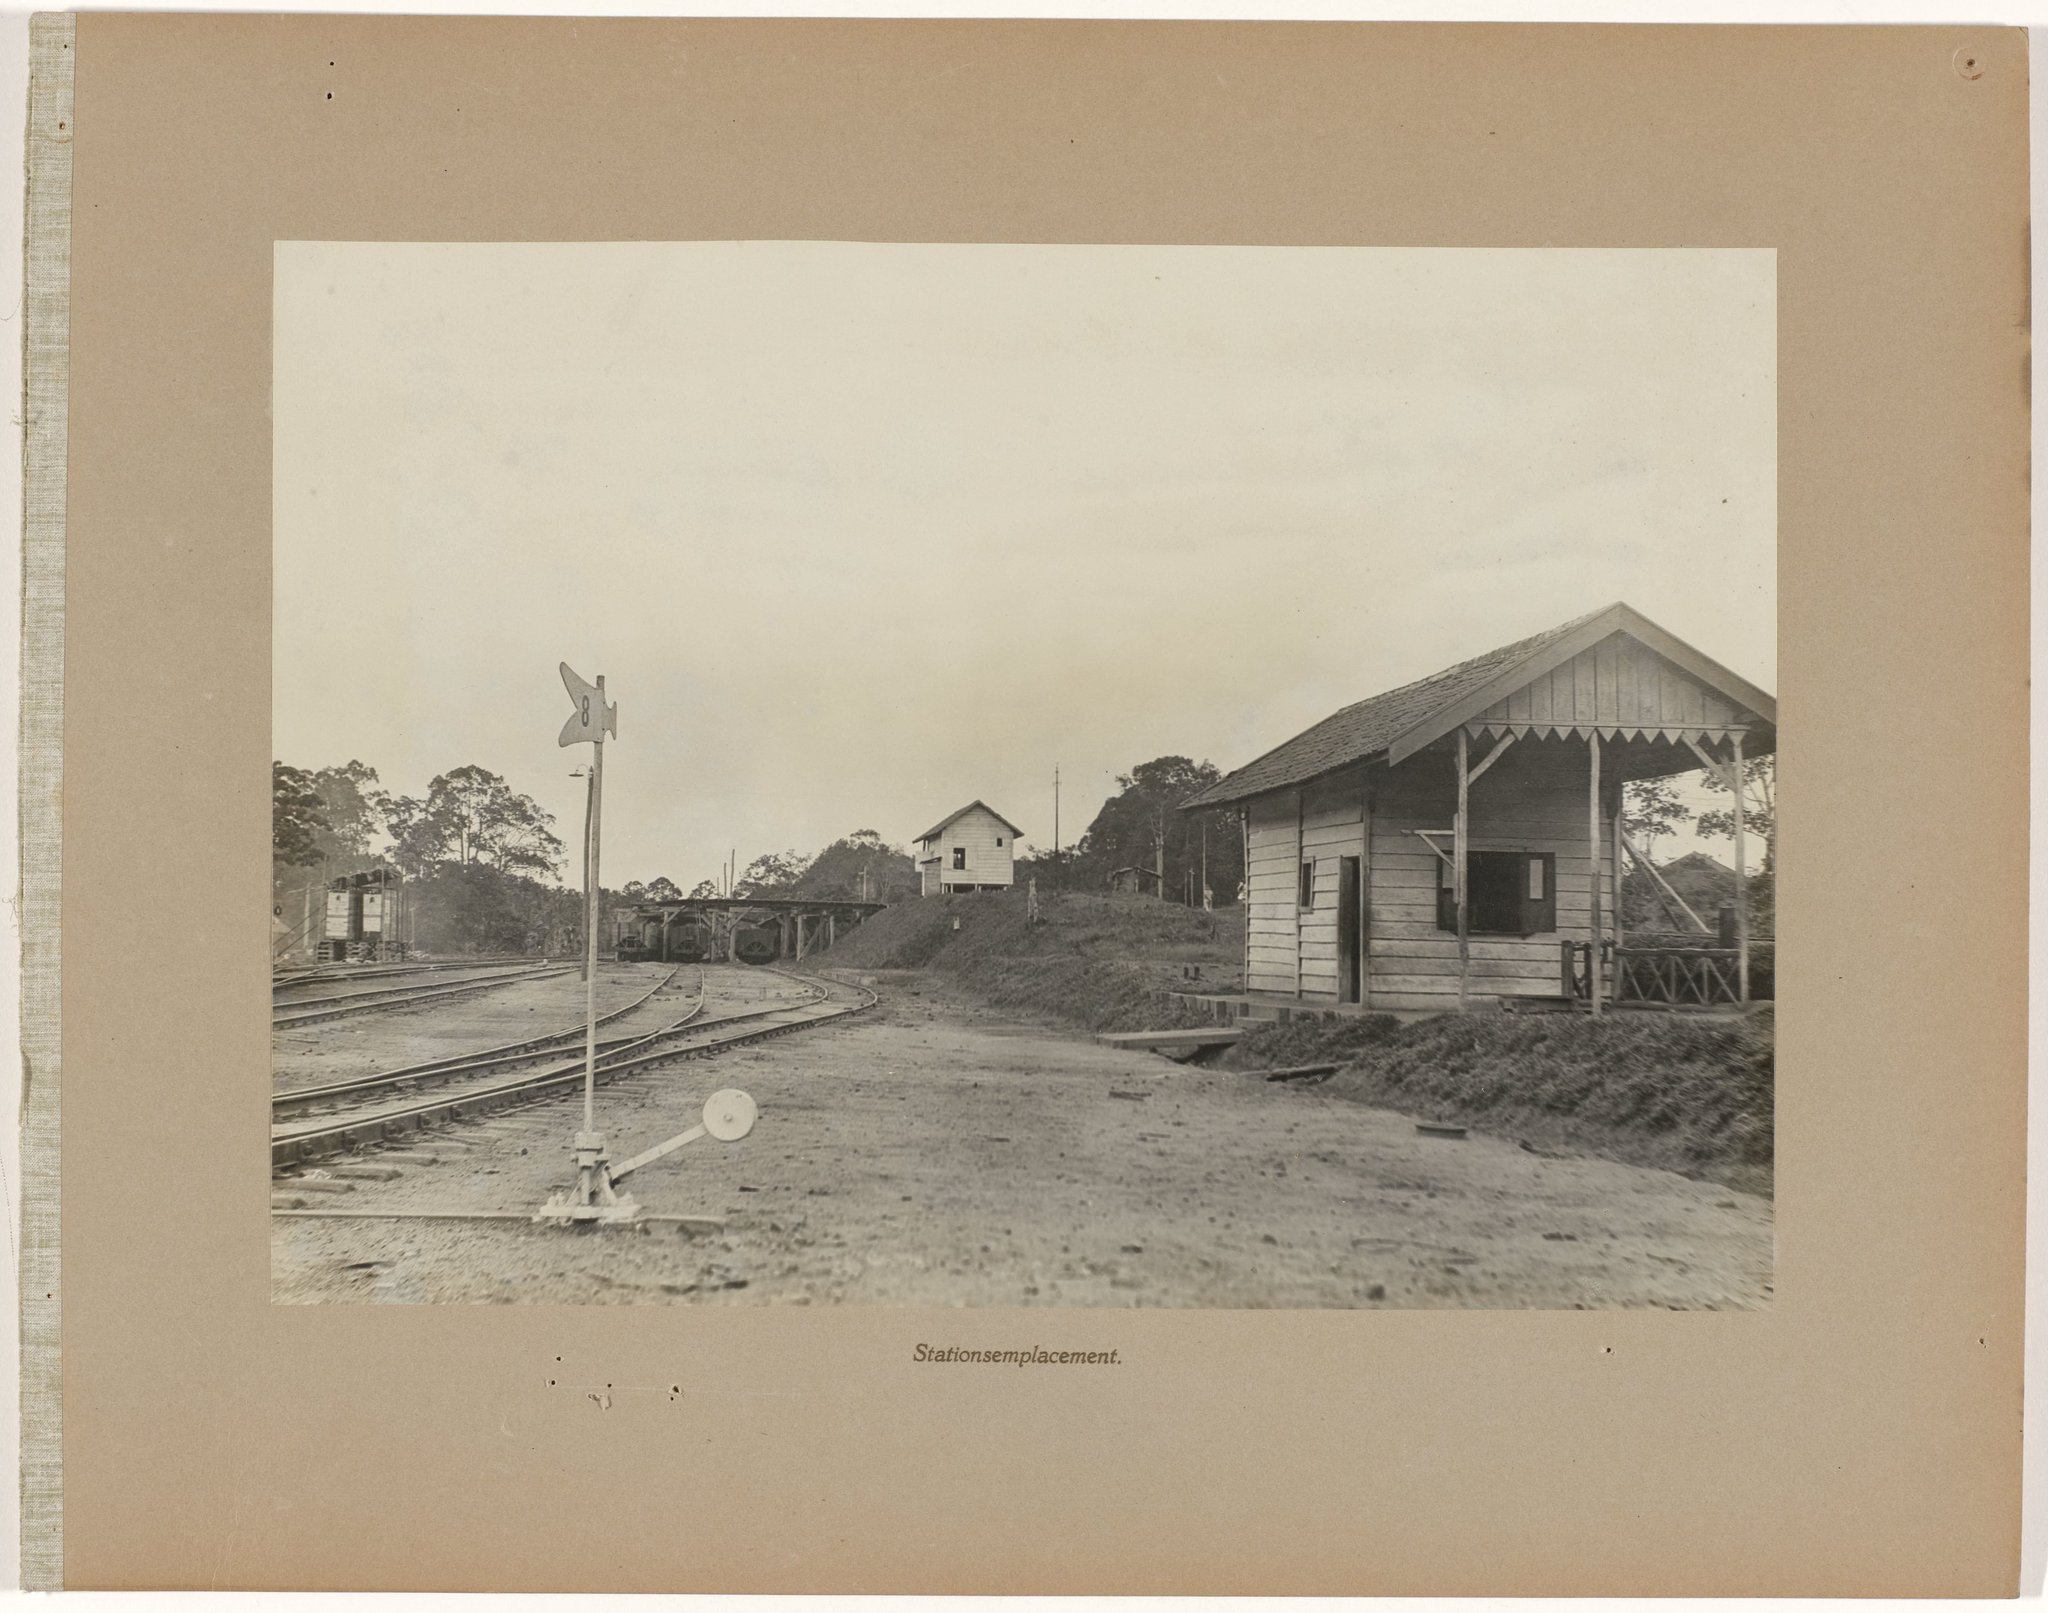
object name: photograph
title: Stationsemplacement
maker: Anonymous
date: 1921-1922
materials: photographic support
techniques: gelatin silver print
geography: bukit asam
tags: colonial system, anthracite, hard coal, opencast mine; strip mining (+ coal), station; shelter (railway, tramway), sumatra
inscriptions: inscription: ‘Stationsemplacement.’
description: Gezicht op het stationsemplacement, nabij de kolenmijn. Onderdeel van het losbladige fotoalbum aangeboden door het personeel van de Boekit-Asam Steenkolenmijnen op Sumatra aan de scheidende Ingenieur-Directeur H. Tromp op 7 januari 1922.